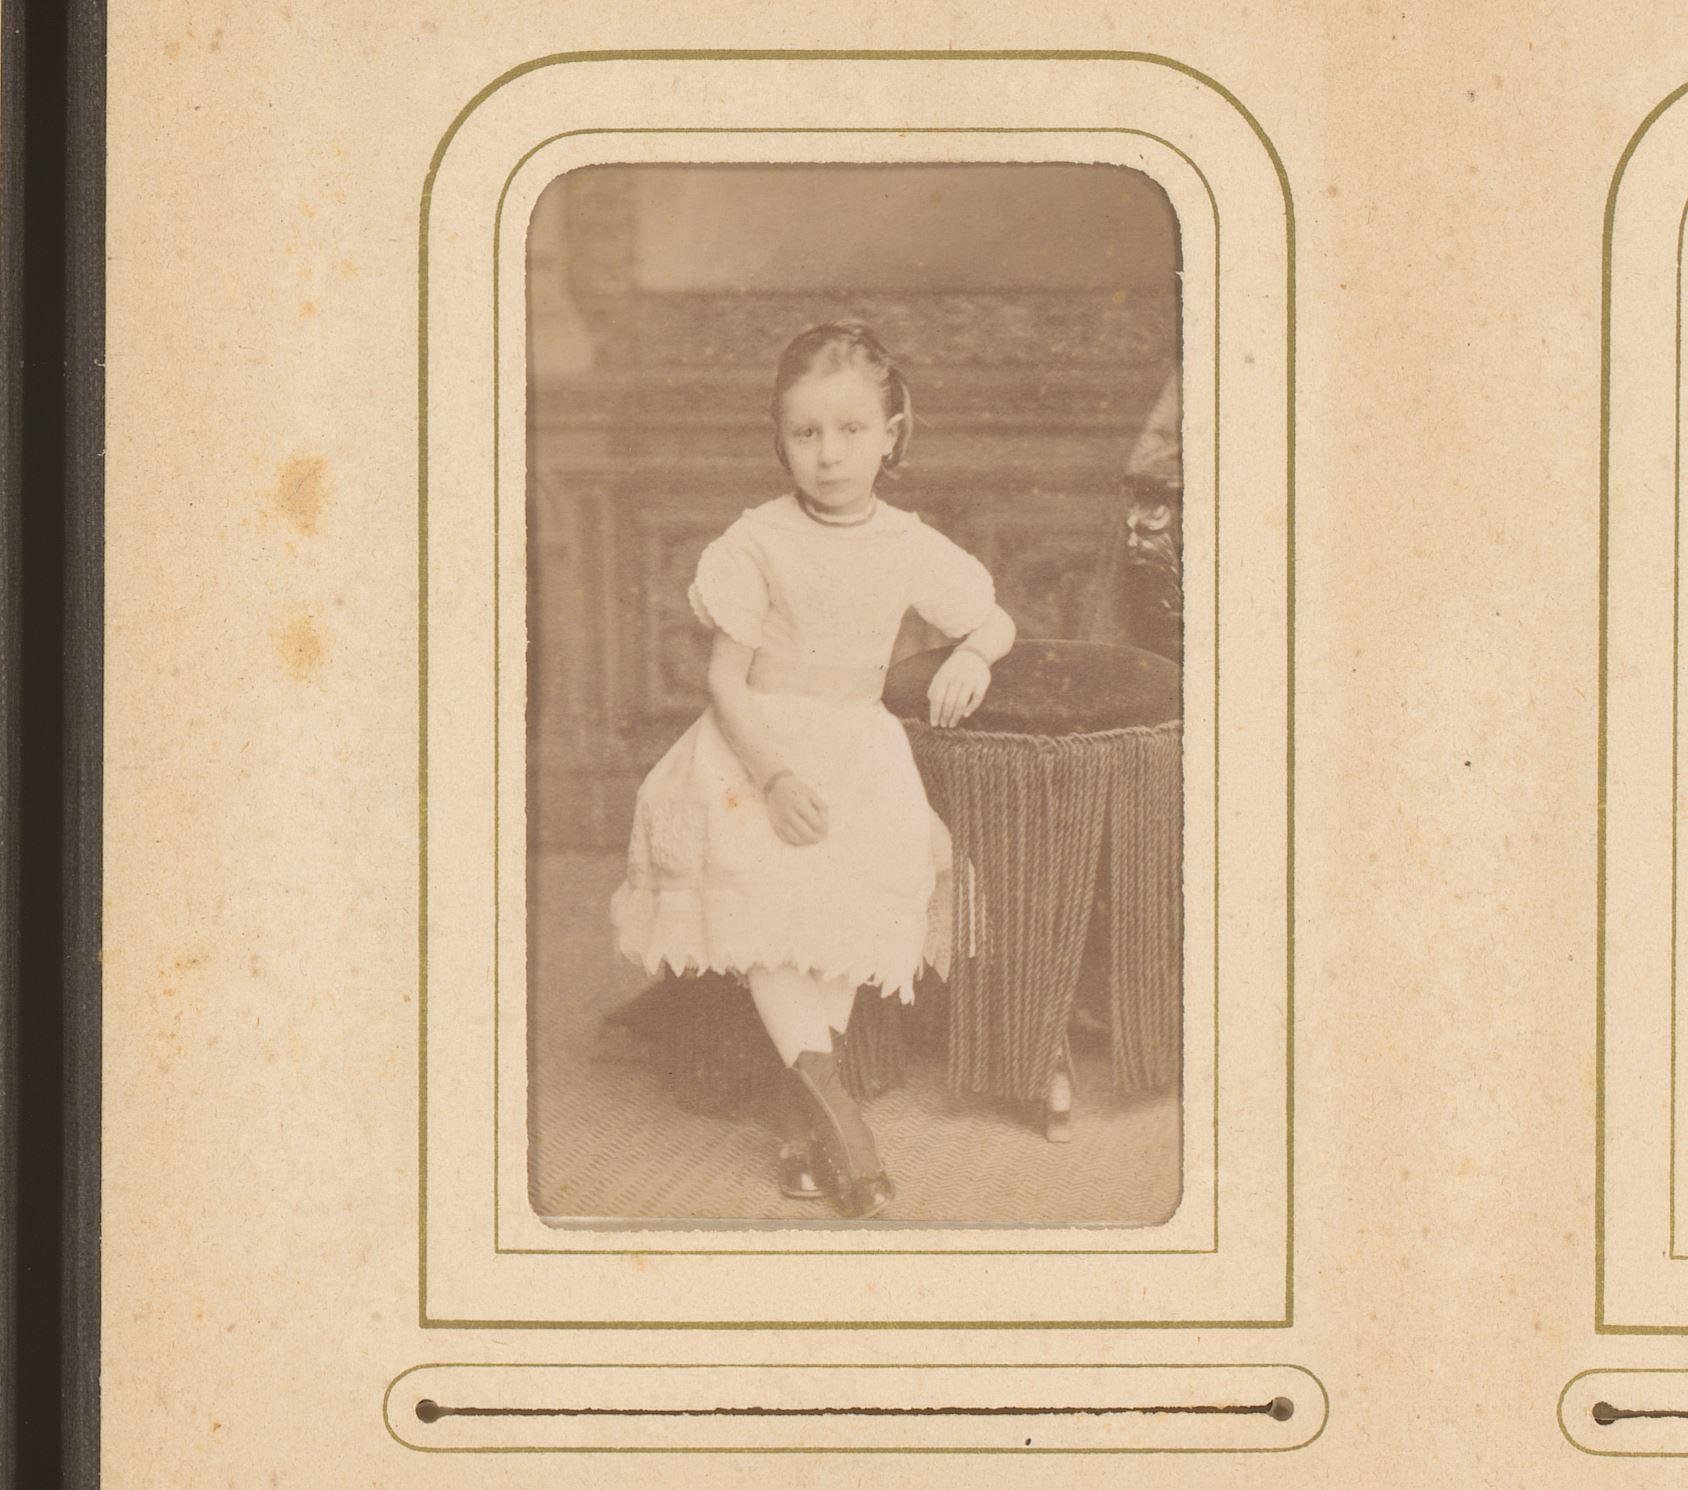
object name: photograph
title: Portret van een meisje, staand bij een tafel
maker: johannes wilhelmus franciscus offenberg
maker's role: fotograaf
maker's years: 1839-1919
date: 1867-1888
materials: cardboard, photographic support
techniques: albumen print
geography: amsterdam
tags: historical persons - bb - woman, table, toddler (female)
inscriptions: inscription: ‘OFFENBERG/ PHOTOGRAPHE/ DE S.M. LA REINE DES PAYS BAS/ DAMSTRAAT/ Amsterdam/ (...)/ RÉCOMPENSES./ POUR ÉPREUVES AU CHARBON’